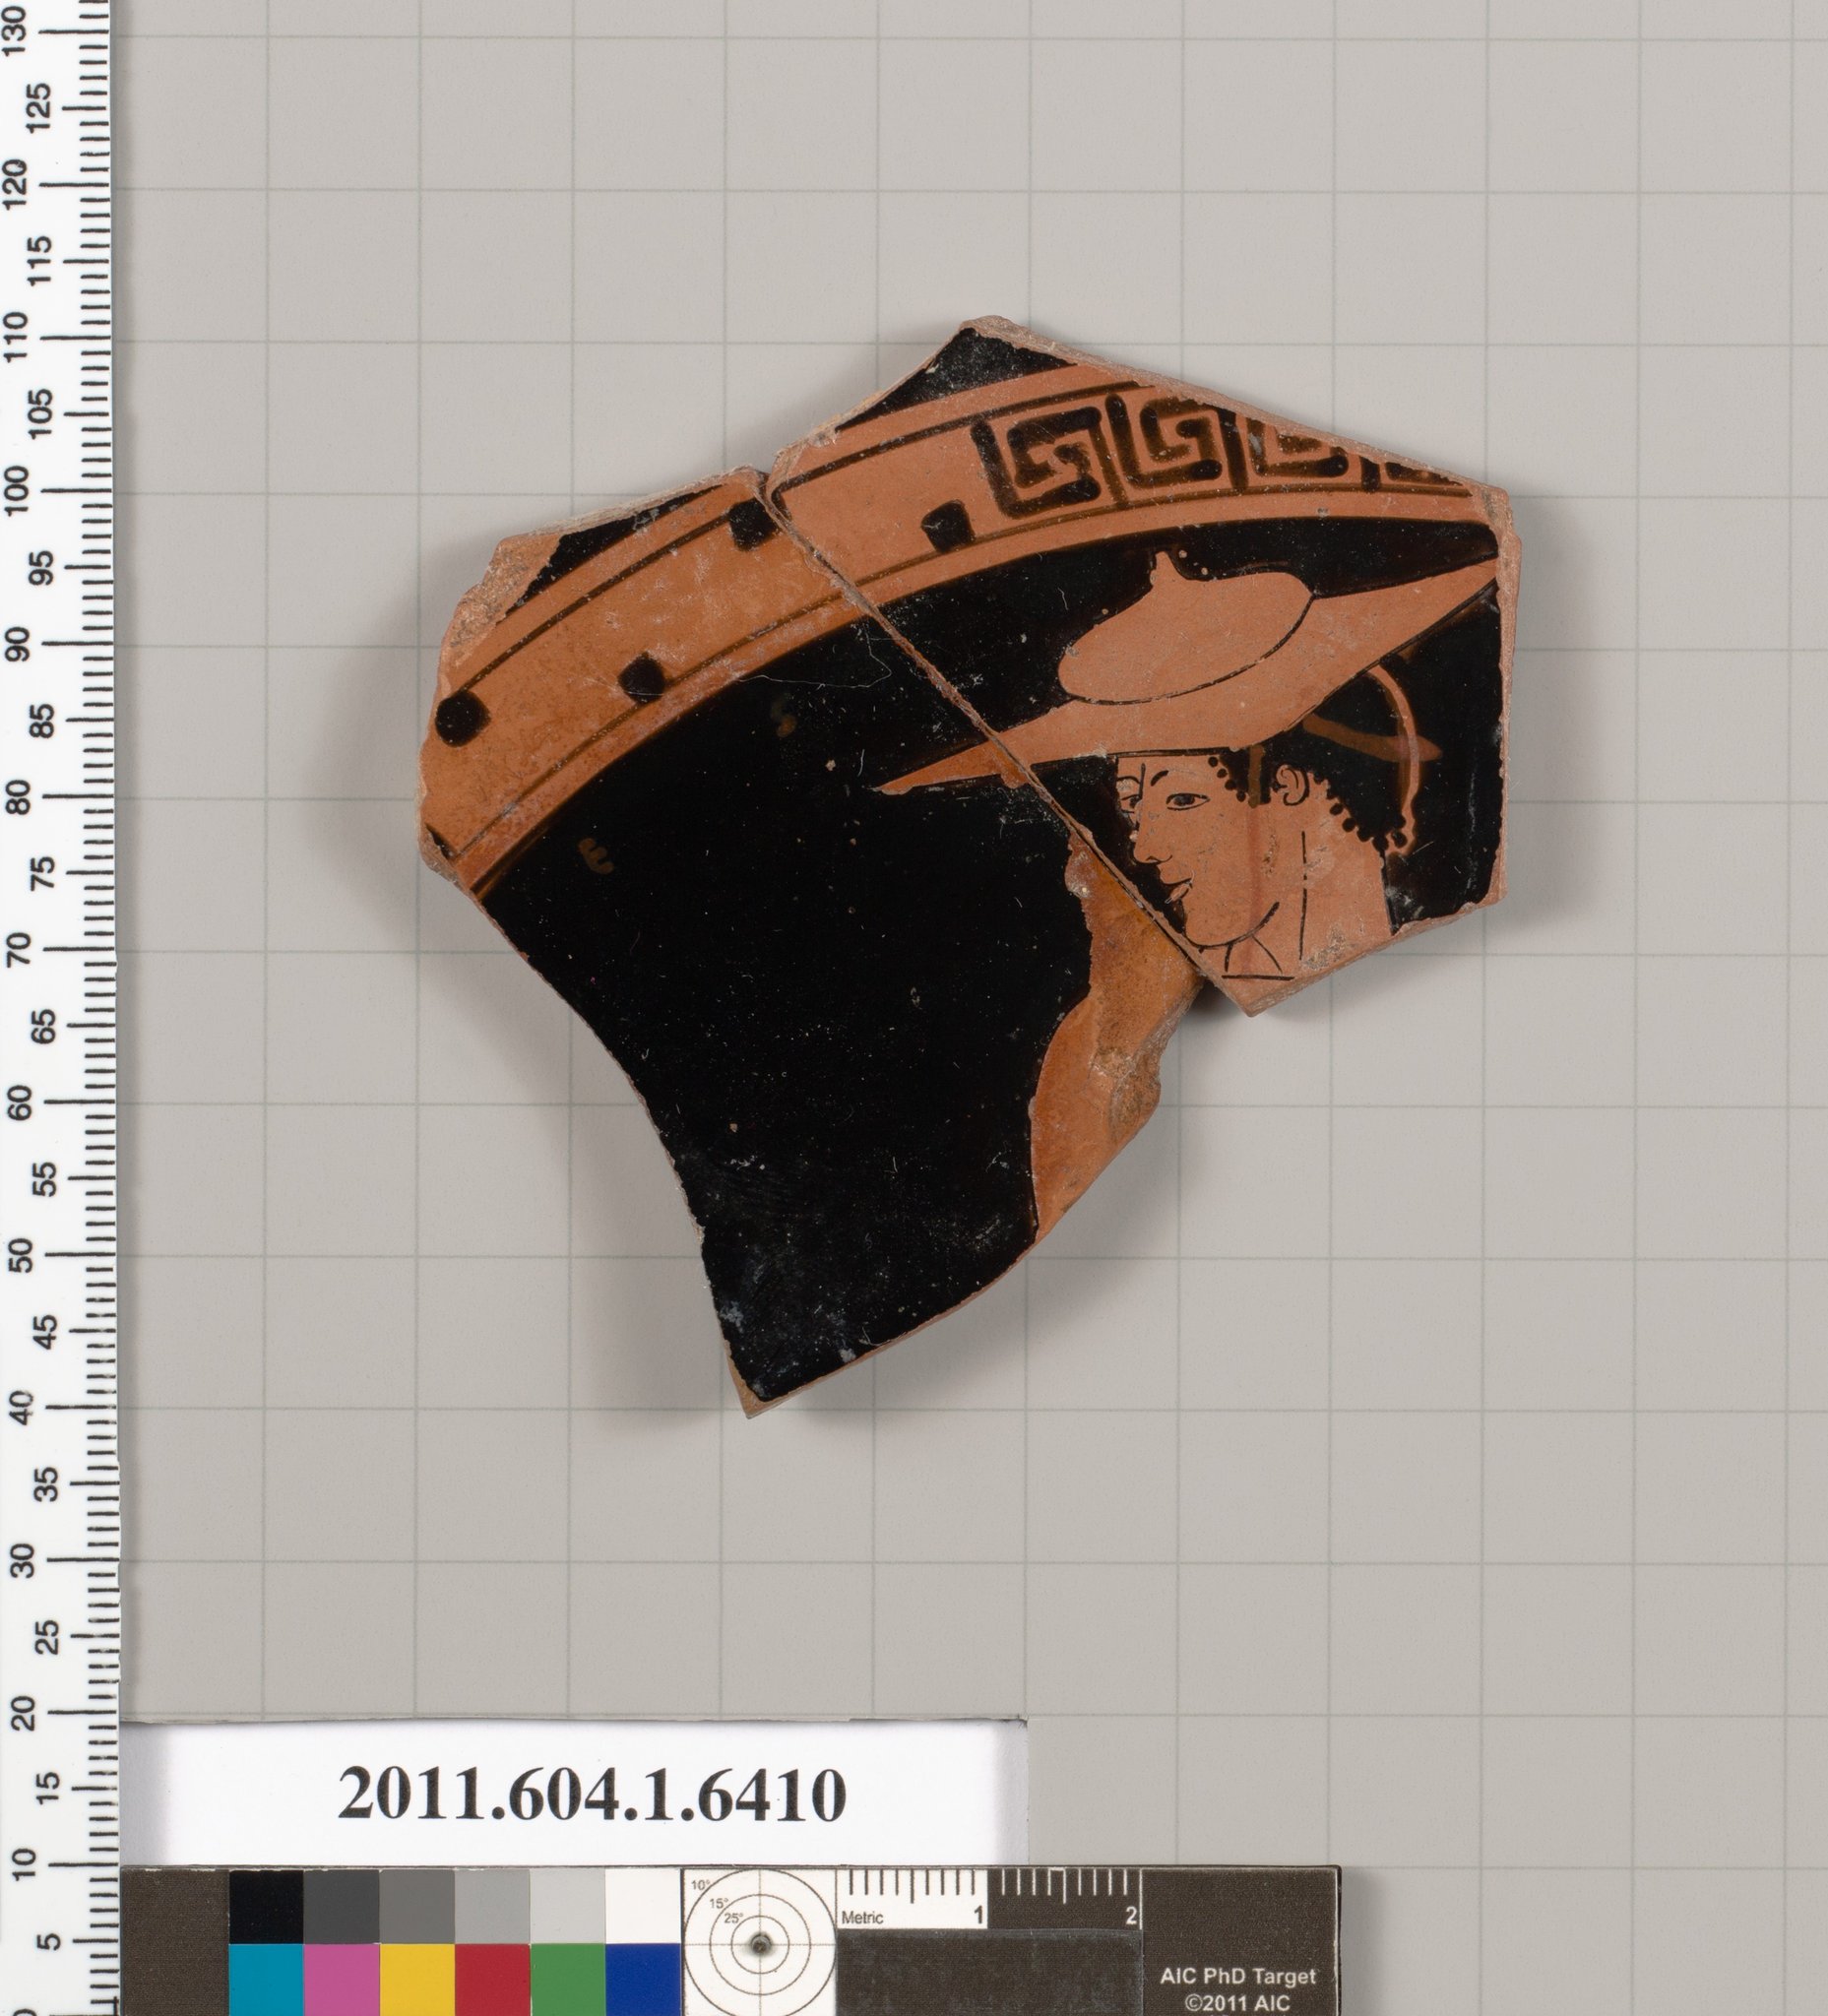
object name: kylix fragment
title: Terracotta fragment of a kylix (drinking cup)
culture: greek, attic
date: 490-480 BCE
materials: terracotta